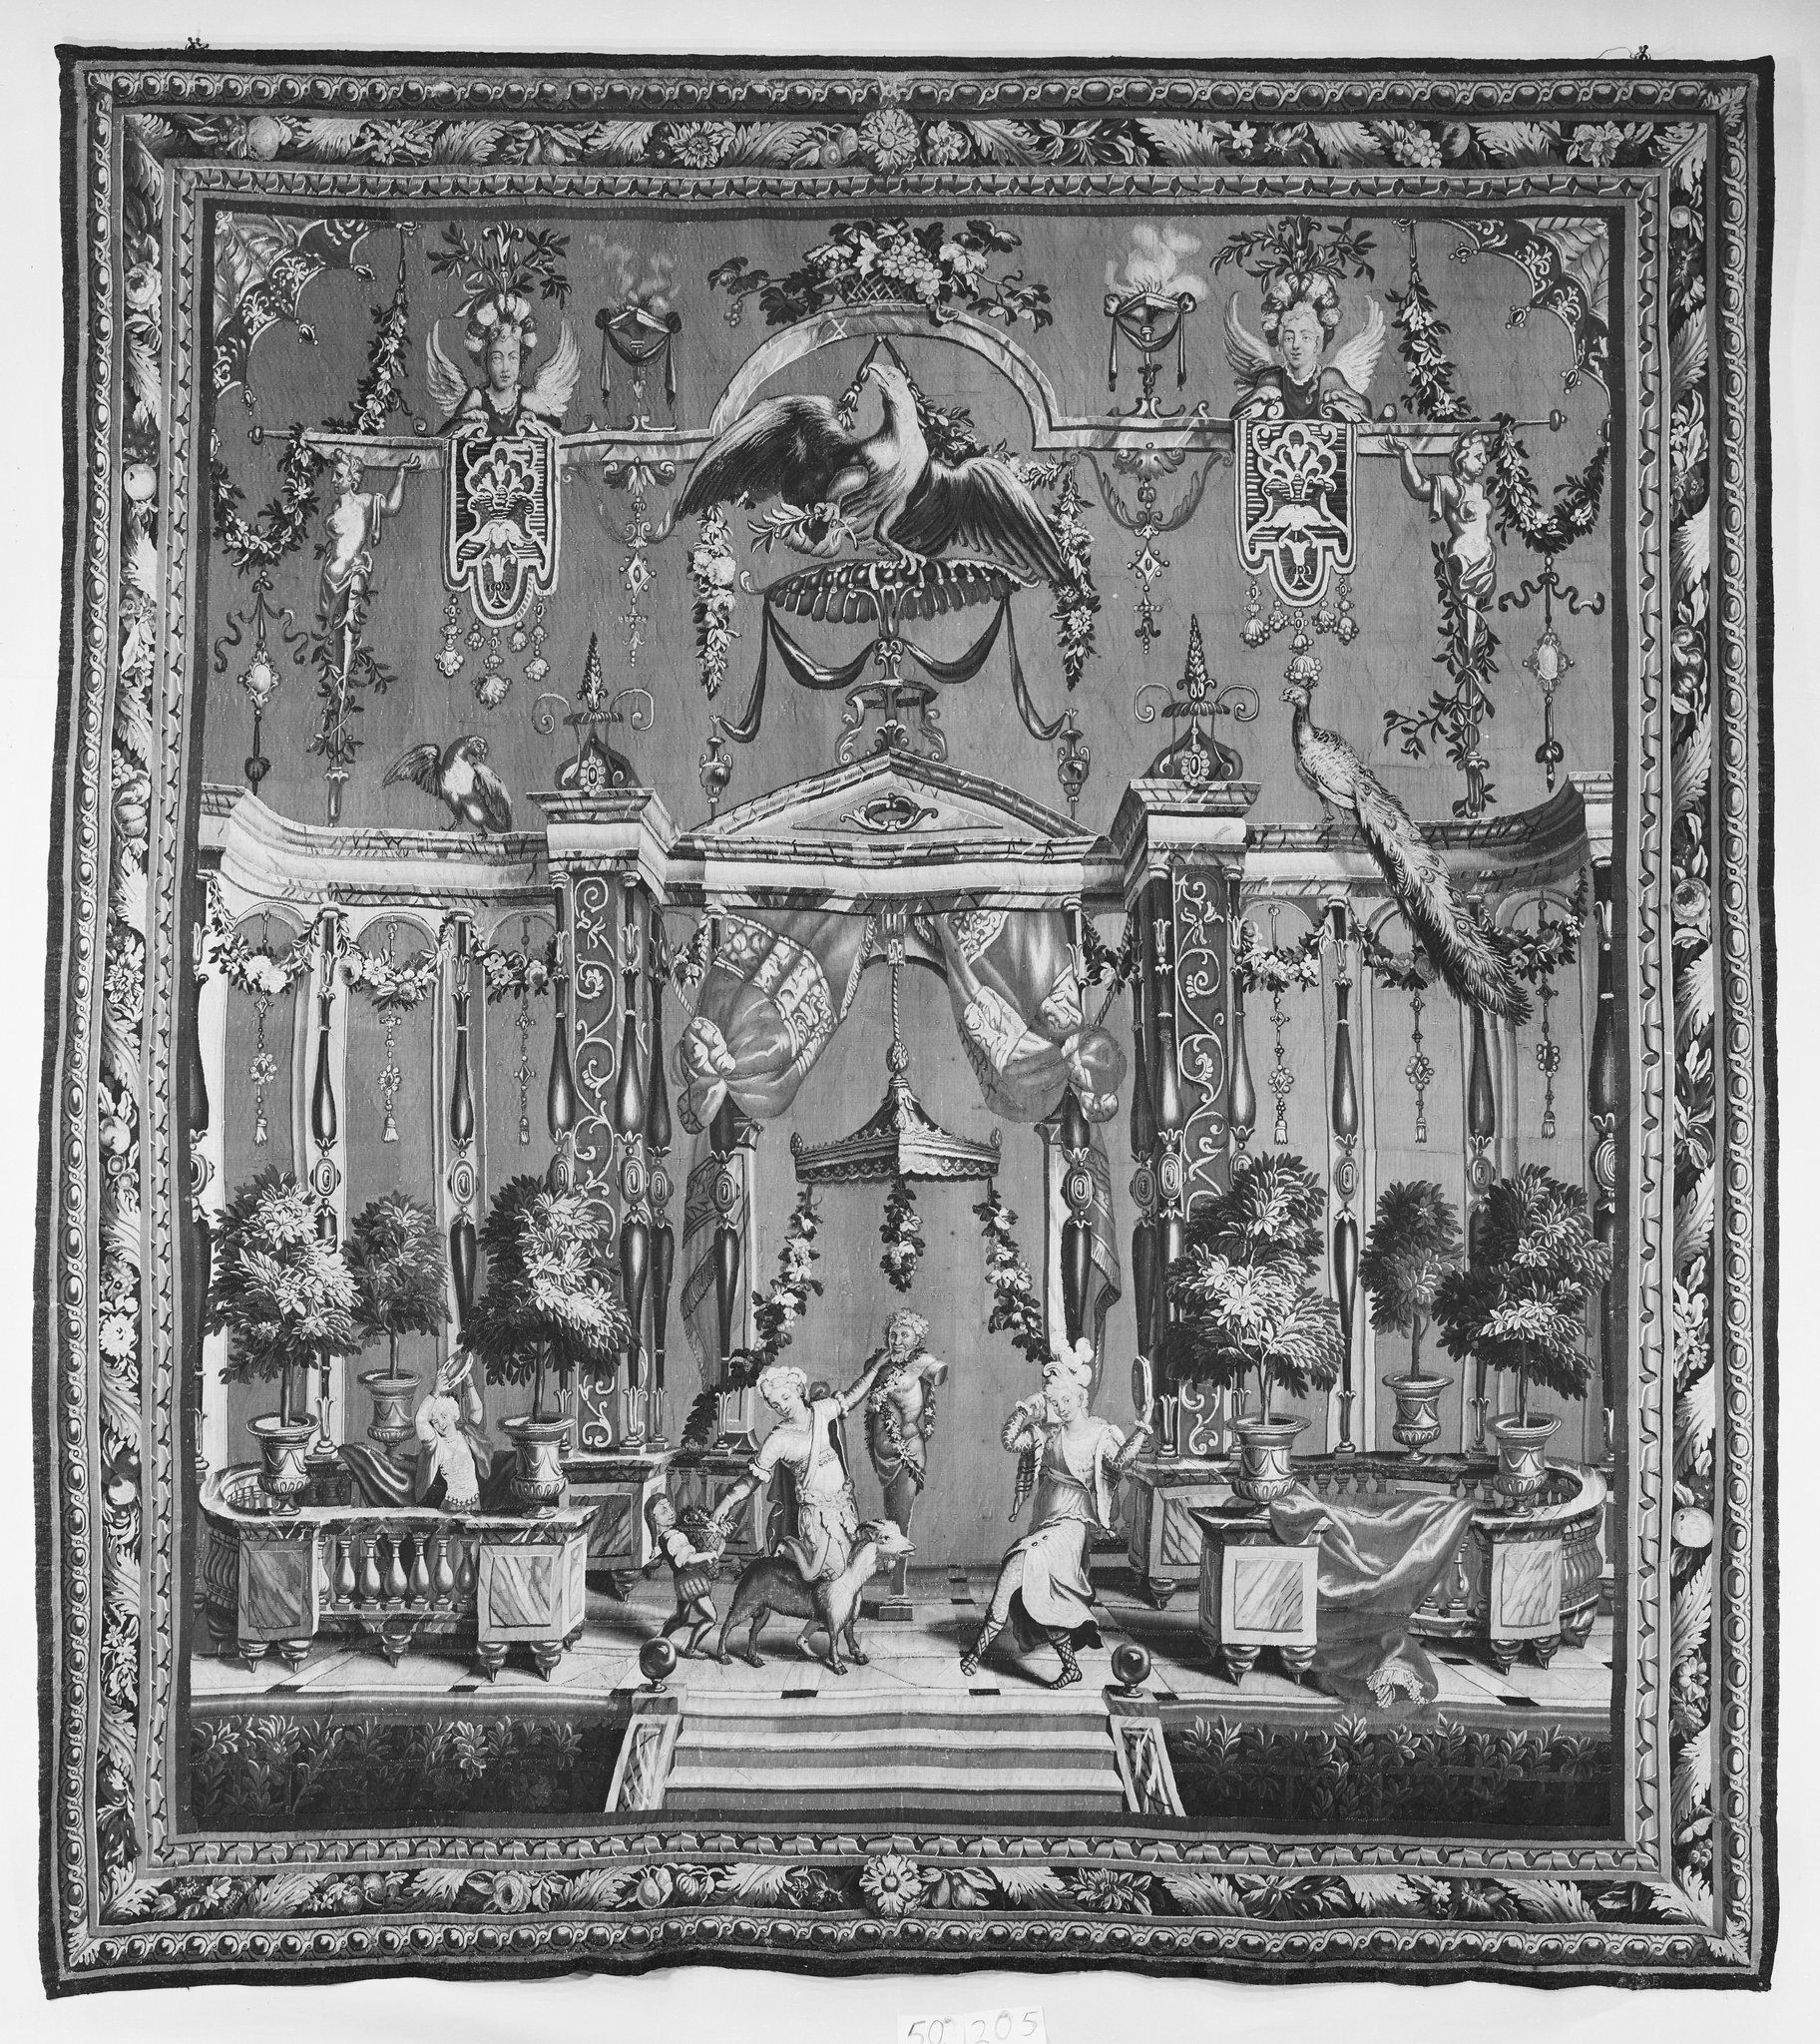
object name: tapestry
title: The Offering to Pan from a set of the Berain Grotesques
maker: jean-baptiste monnoyer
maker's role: designer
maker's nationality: french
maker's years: 1636-1699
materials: silk, wool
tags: birds,fruit,grapes,women,peacocks,goats